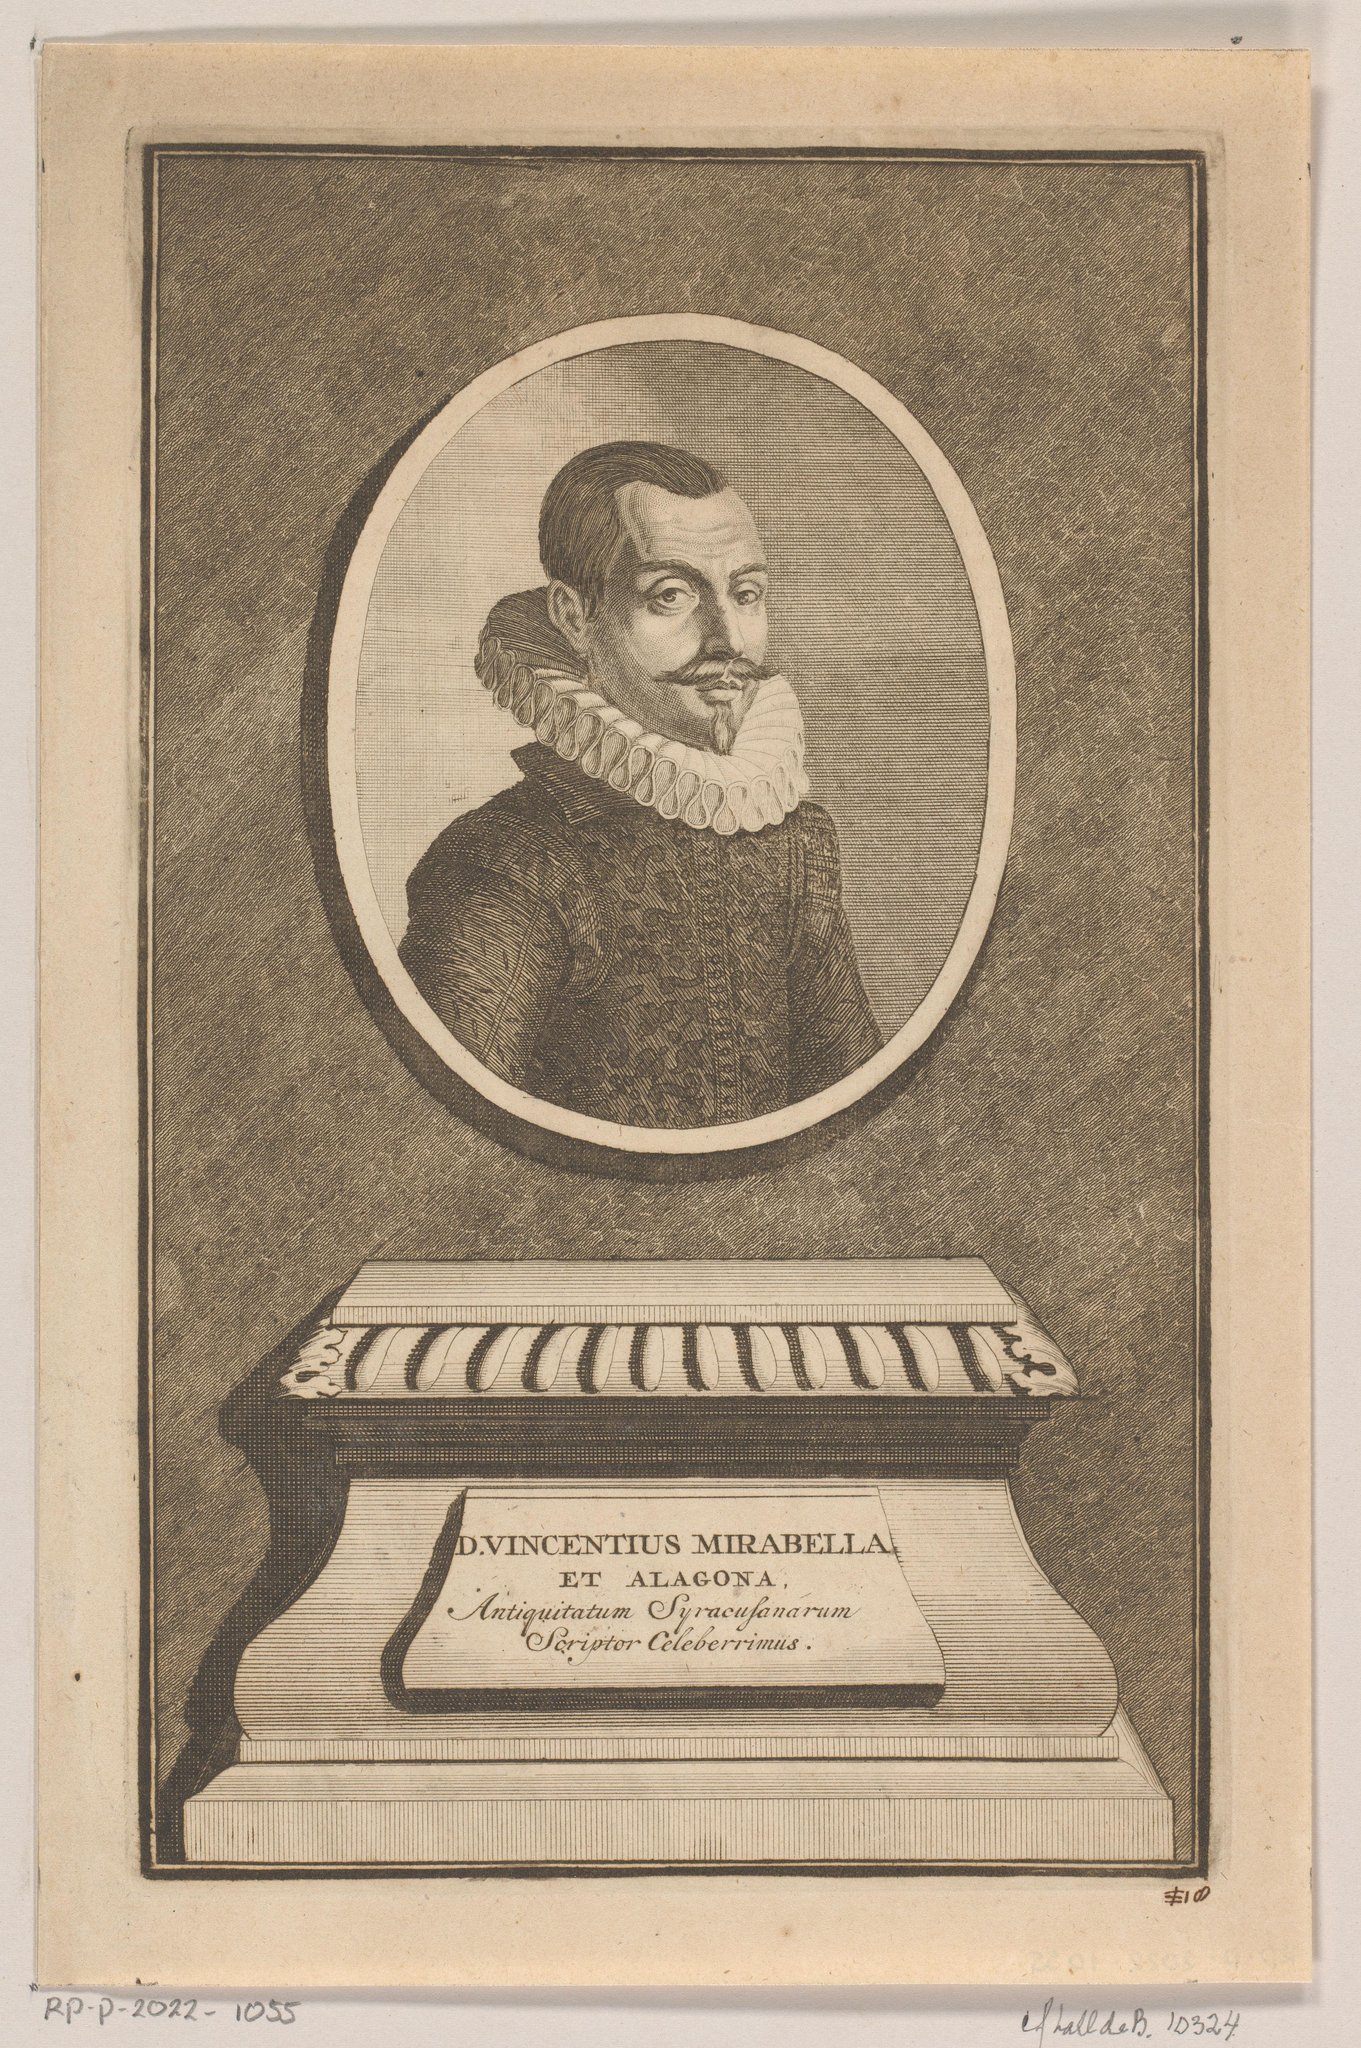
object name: print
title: D. Vincentius Mirabella et Alagona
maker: Anonymous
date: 1650-1750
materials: paper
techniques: engraving, etching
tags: vincenzo mirabella, historical persons, ambassador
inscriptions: inscription: ‘[turfstrepen] 18’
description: Met tweeregelig onderschrift in het Latijn.